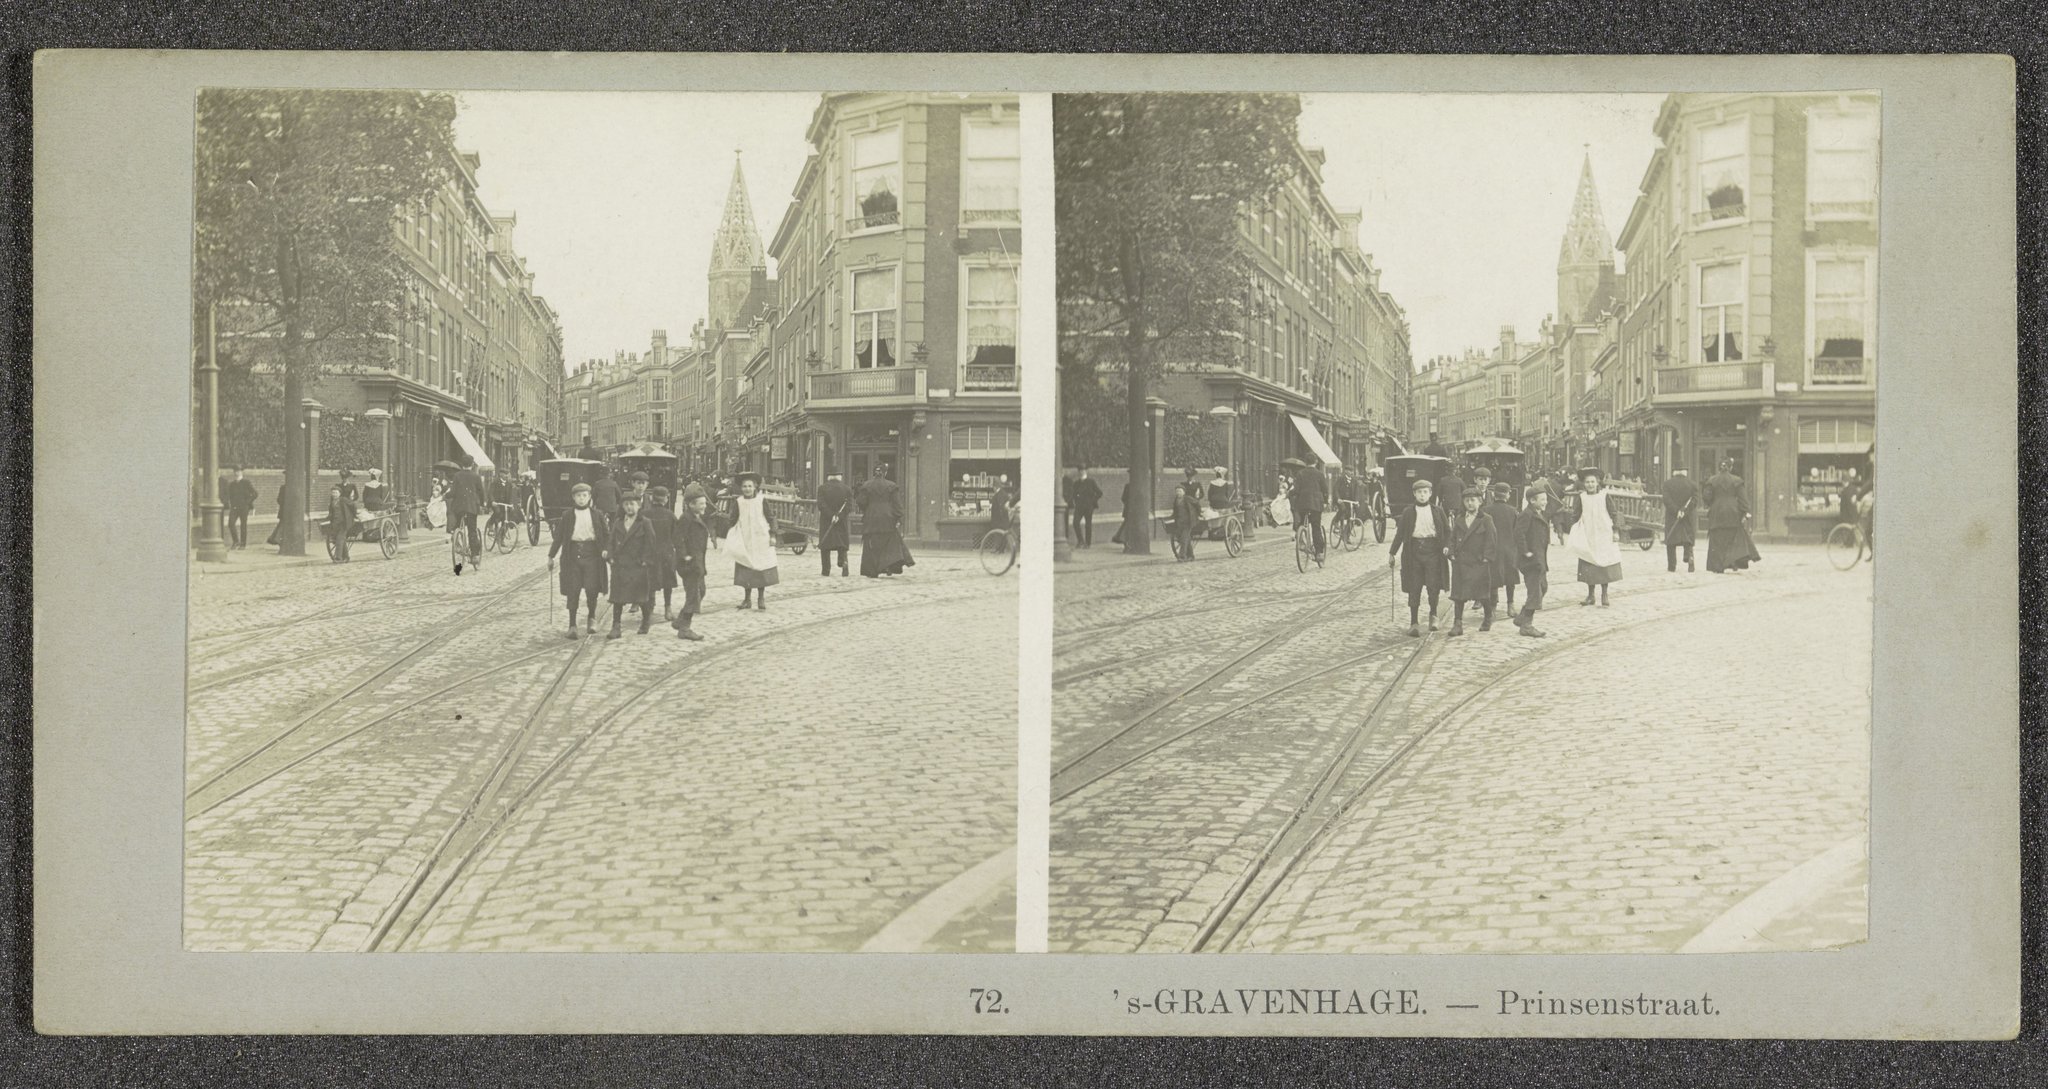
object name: stereograph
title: Gezicht op de Prinsestraat in Den Haag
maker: Anonymous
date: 1882-1920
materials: cardboard, photographic support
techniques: gelatin silver print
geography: the hague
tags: urban housing, street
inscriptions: number: ‘72.’